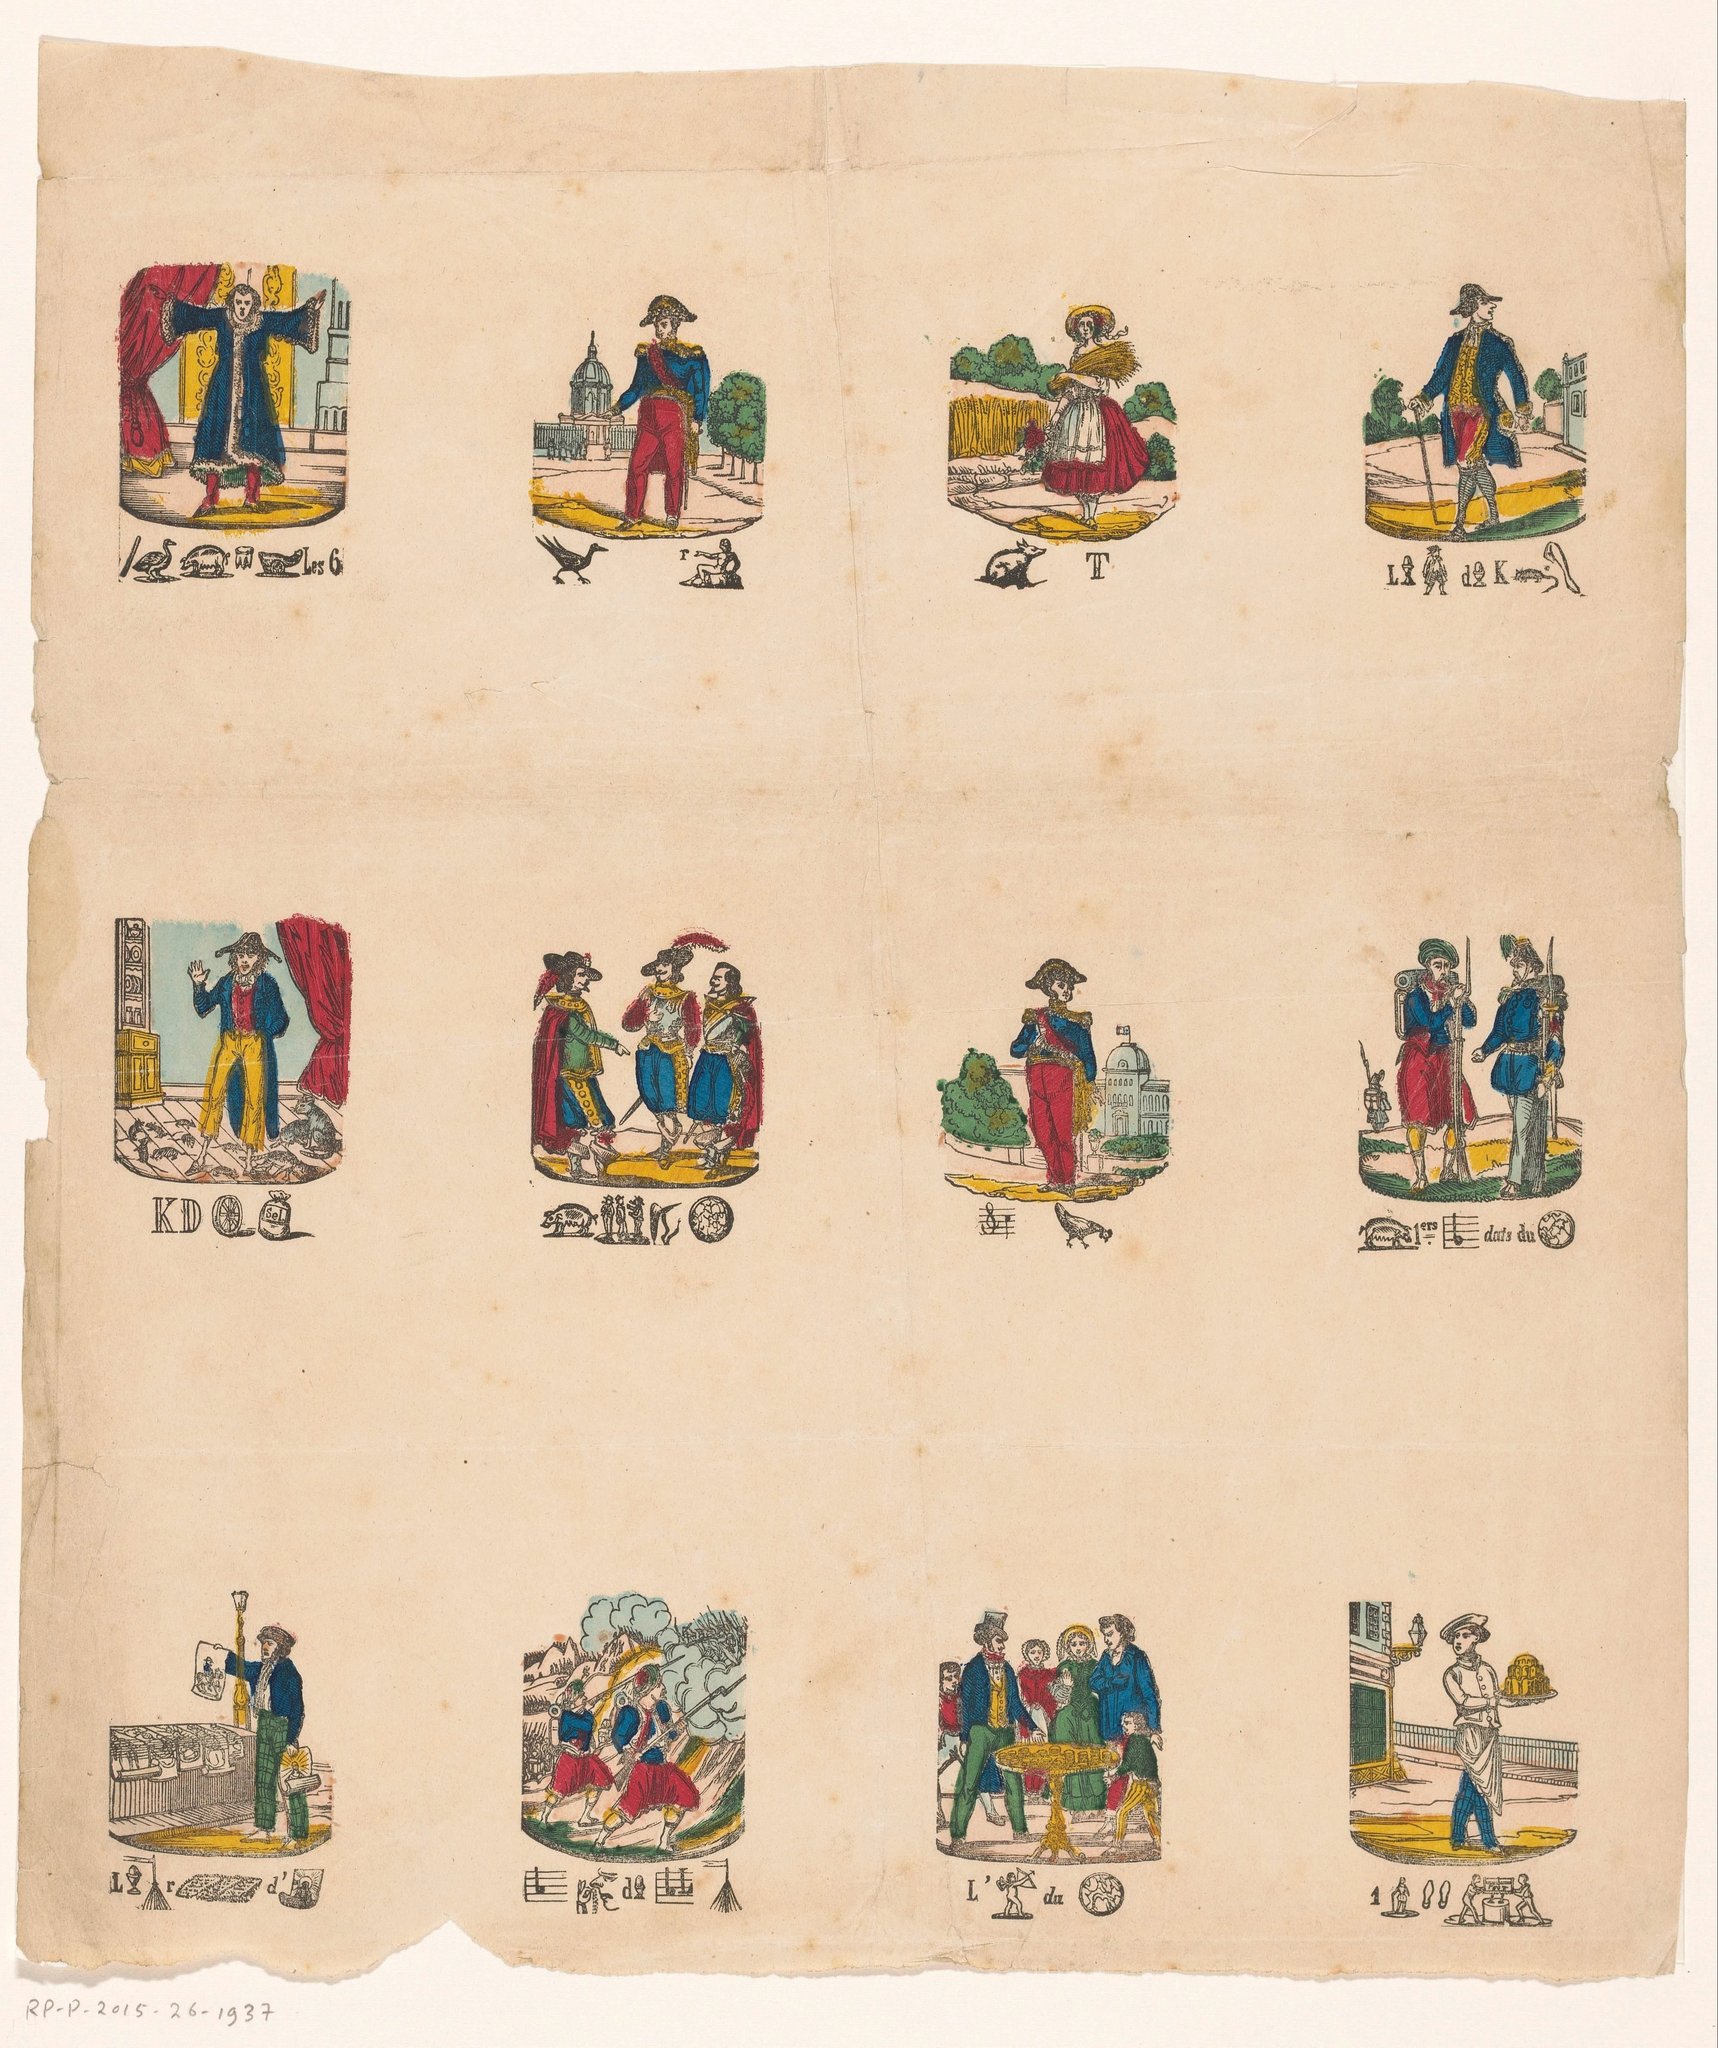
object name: popular print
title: Blad met twaalf rebussen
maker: Anonymous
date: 1825-1900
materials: paper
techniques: hand coloring, lithograph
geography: france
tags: private soldier, art dealer (+ graphic arts)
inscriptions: collector's mark: Lugt 2228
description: Blad met twaalf verschillende scènes, elk met een rebus in het Frans. De voorstellingen tonen onder meer een boerin, soldaten, een prenthandelaar en een man met een taart in zijn handen.